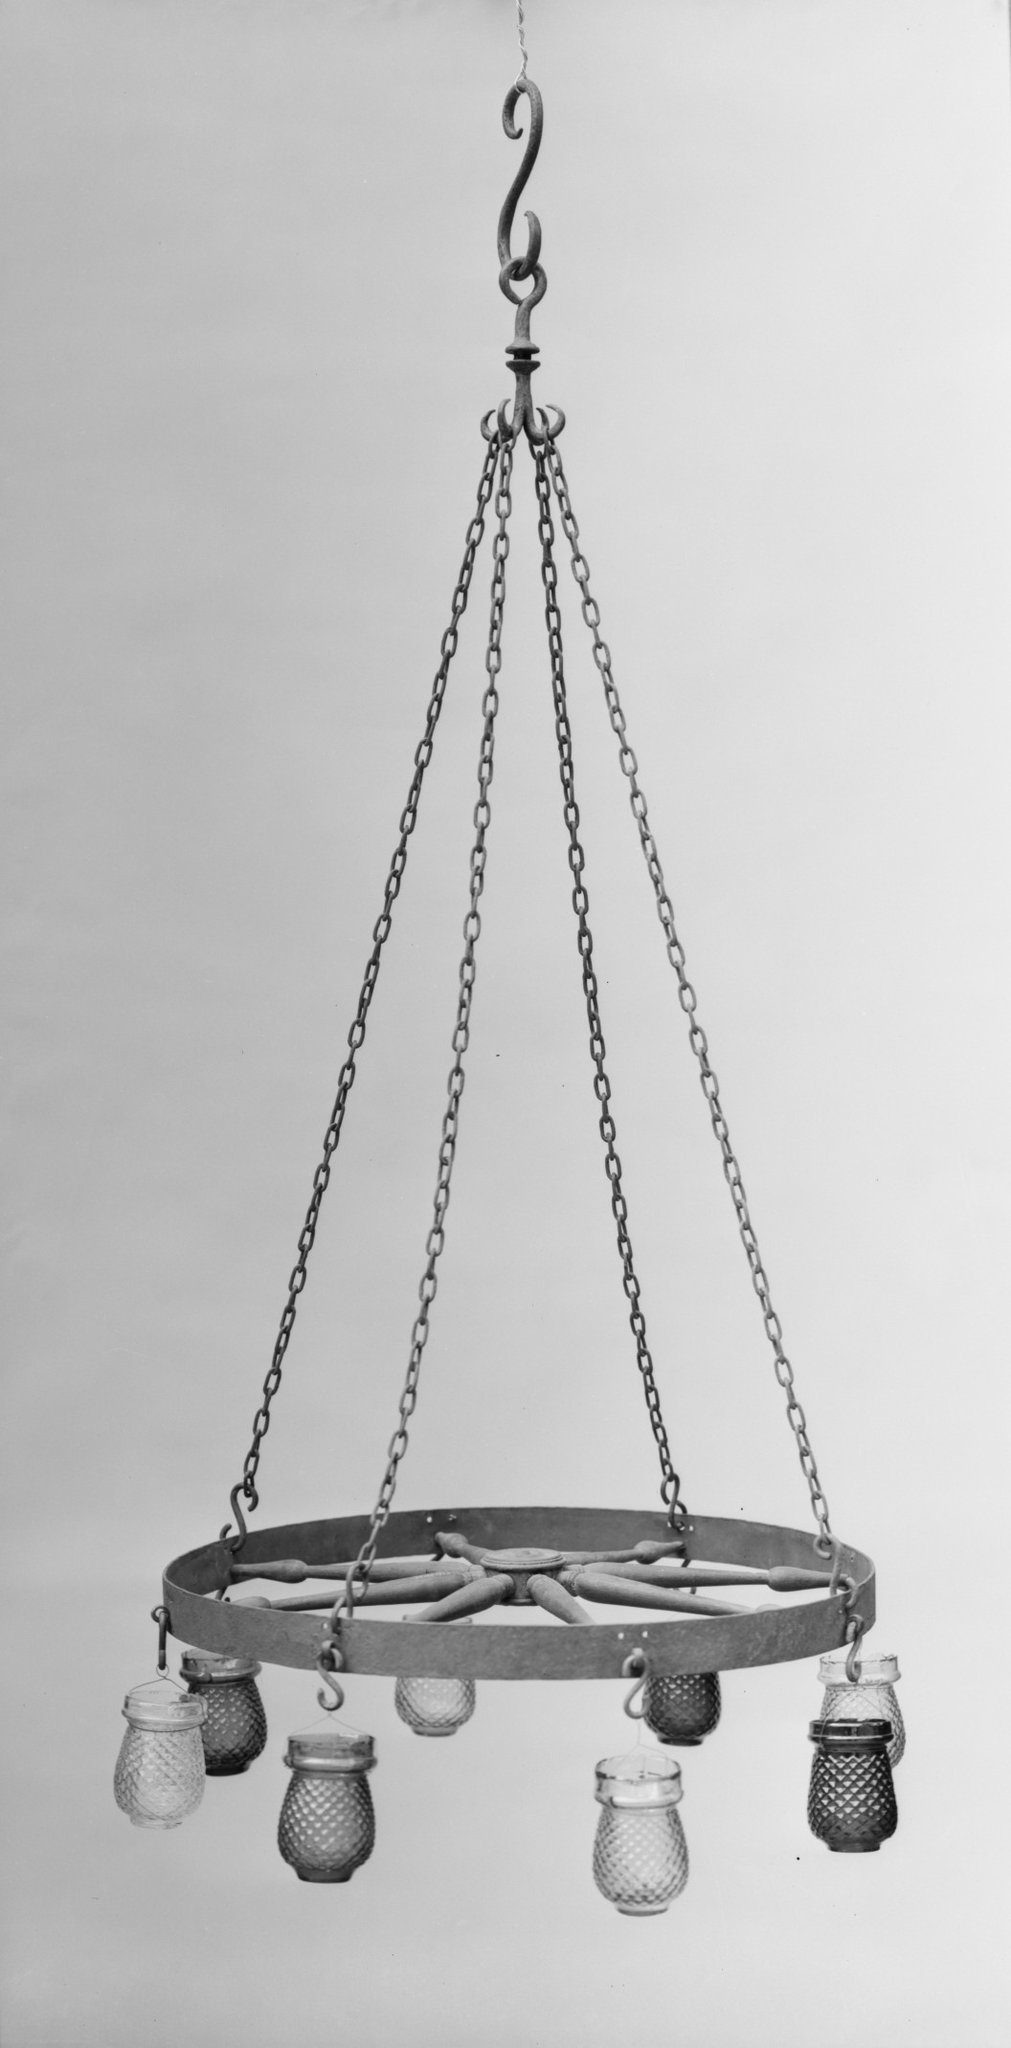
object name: chandelier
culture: american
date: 1700-1800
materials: glass, iron, wood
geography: united states